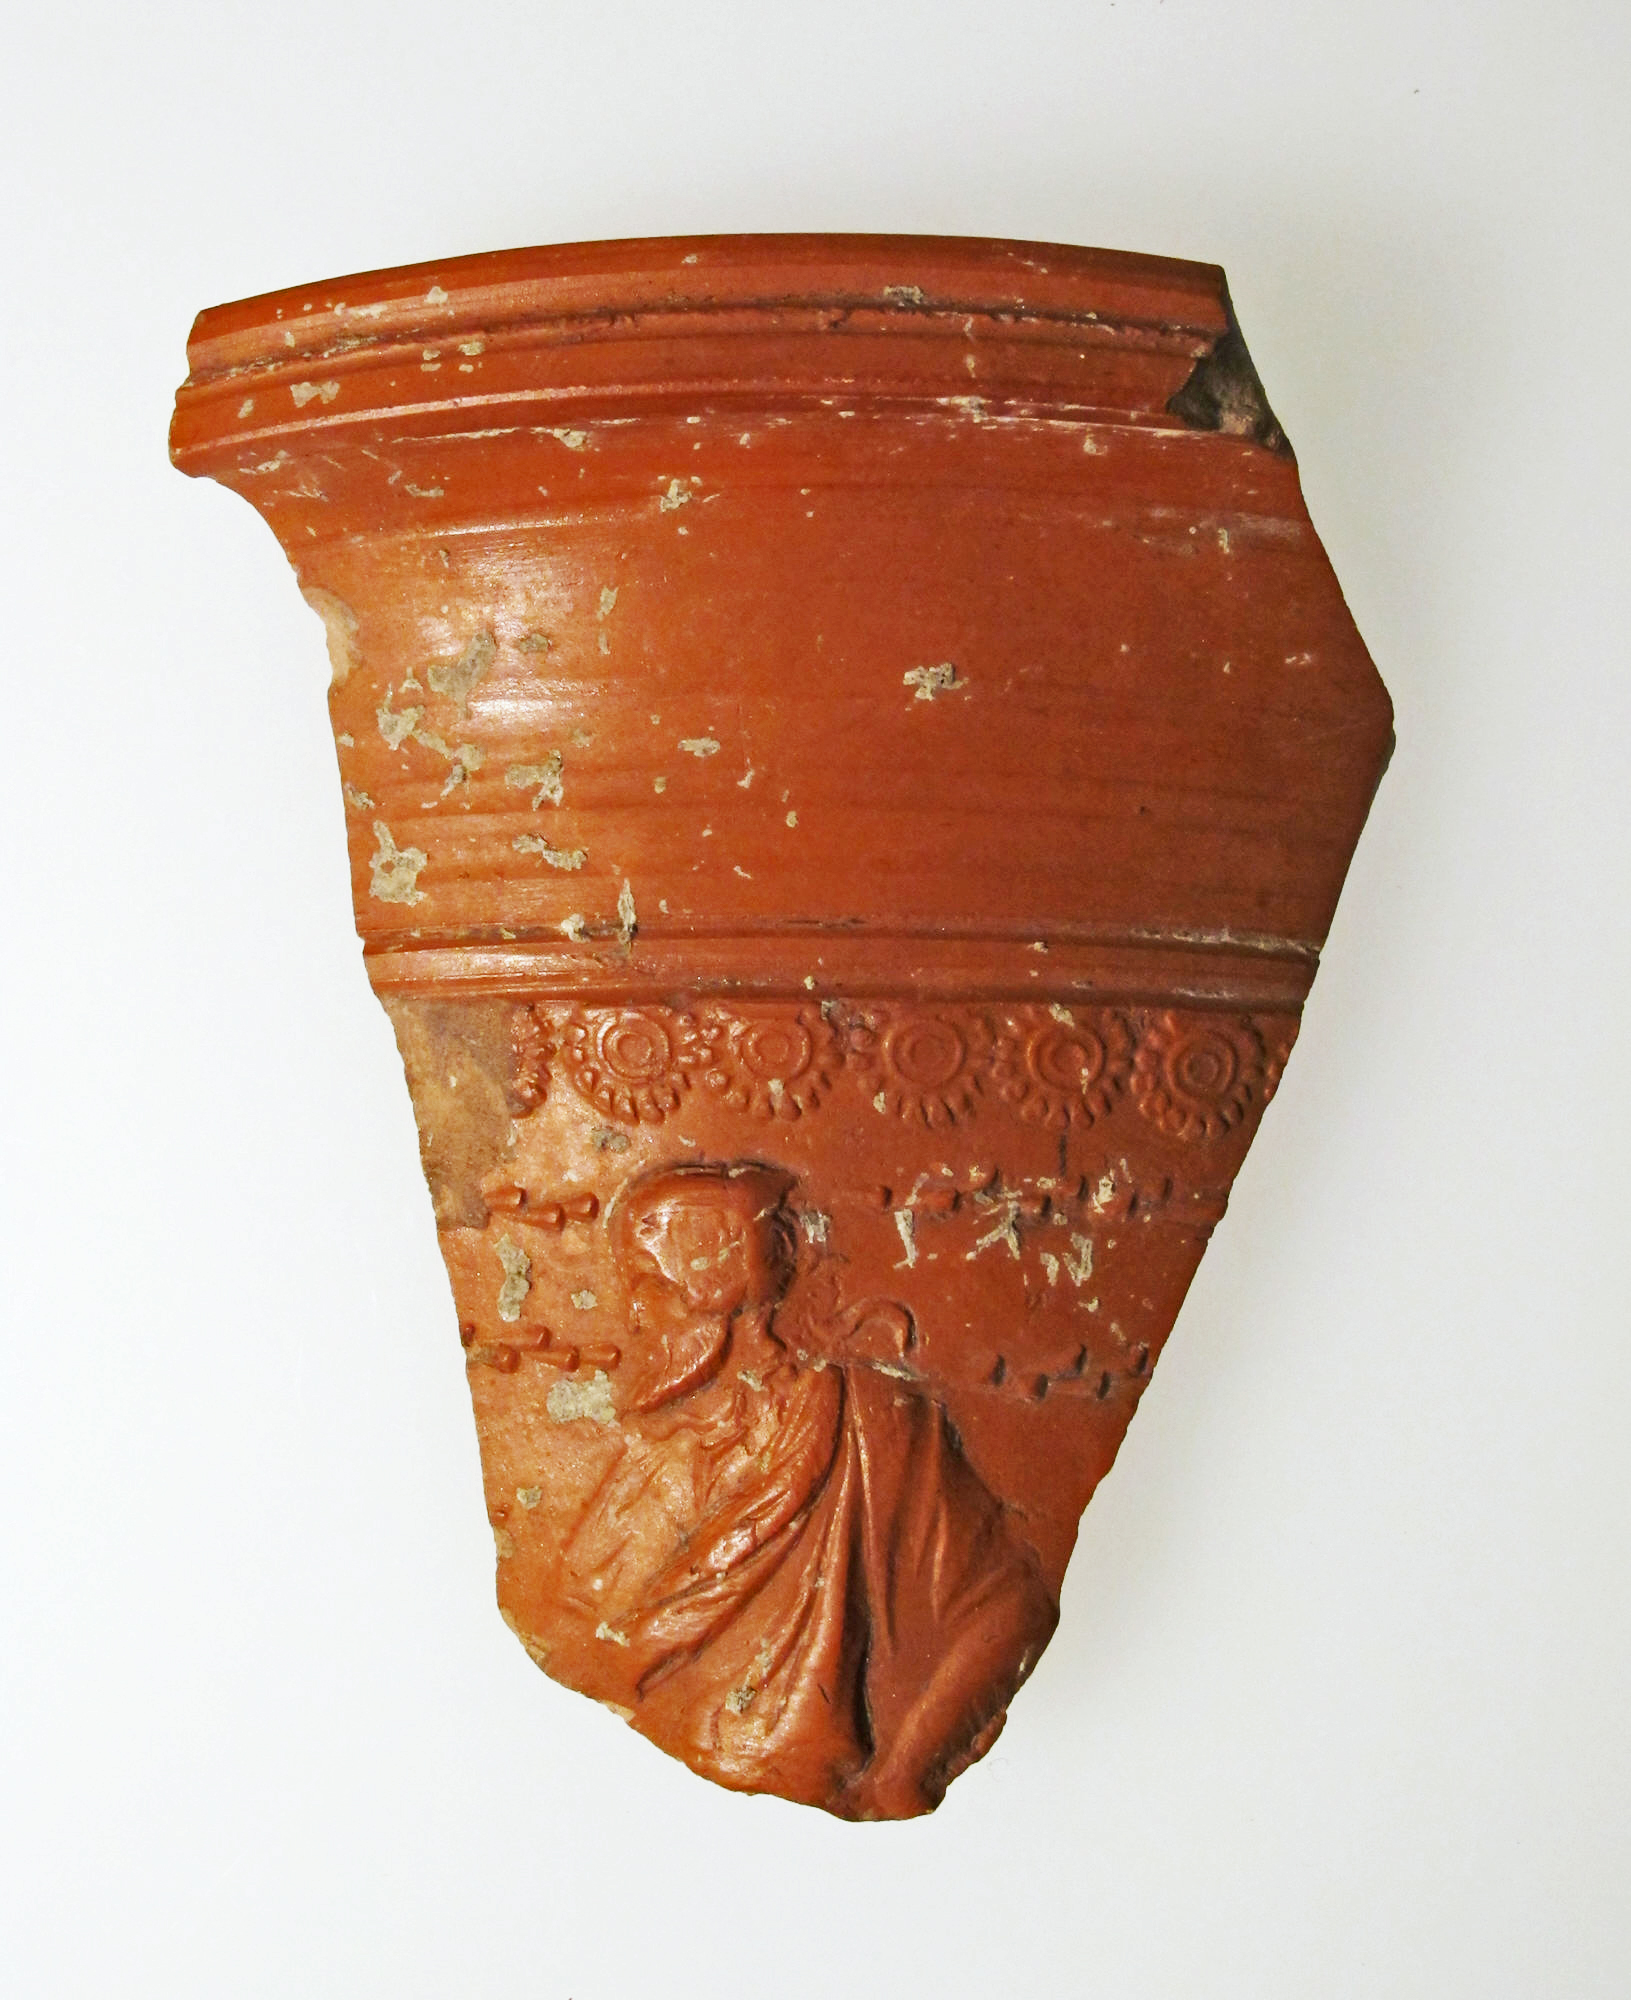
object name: vase fragment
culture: roman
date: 100 BCE-100 CE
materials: terracotta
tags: men,profiles